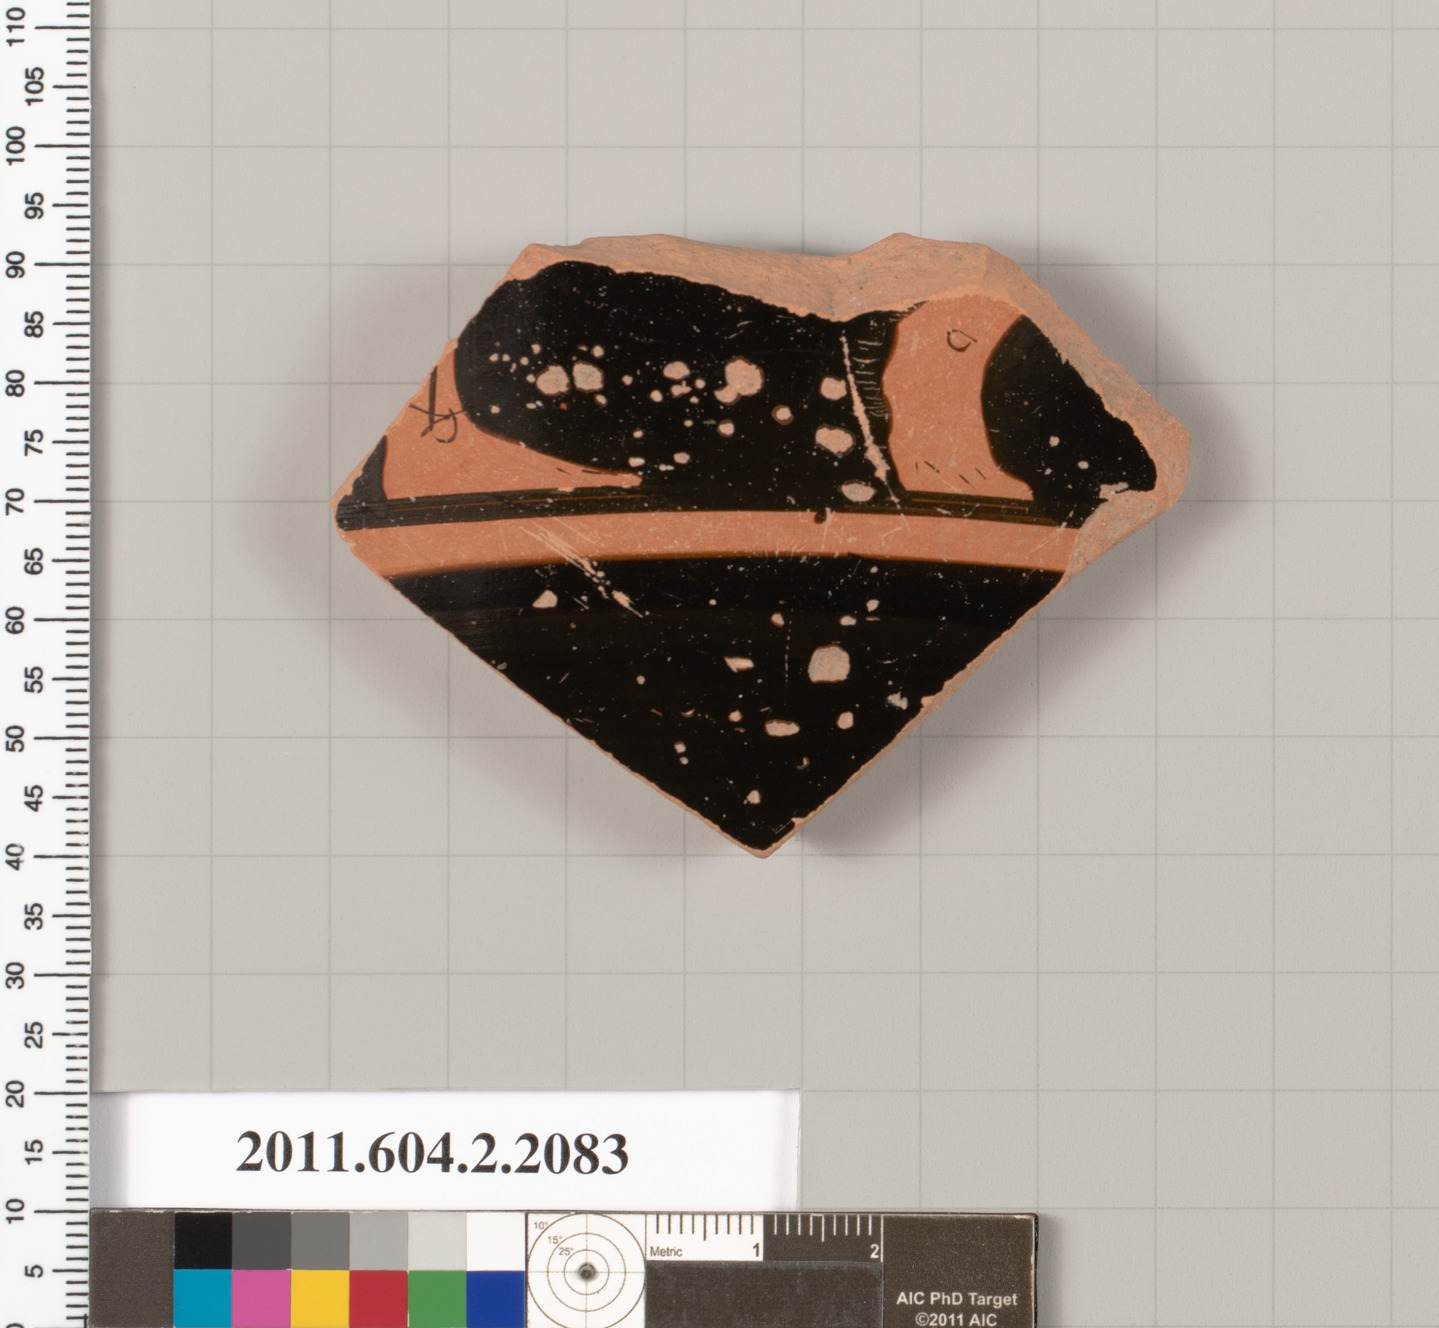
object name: pot fragment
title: Terracotta fragment of a pot; glazed on the inside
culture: greek, attic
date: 450-426 BCE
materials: terracotta